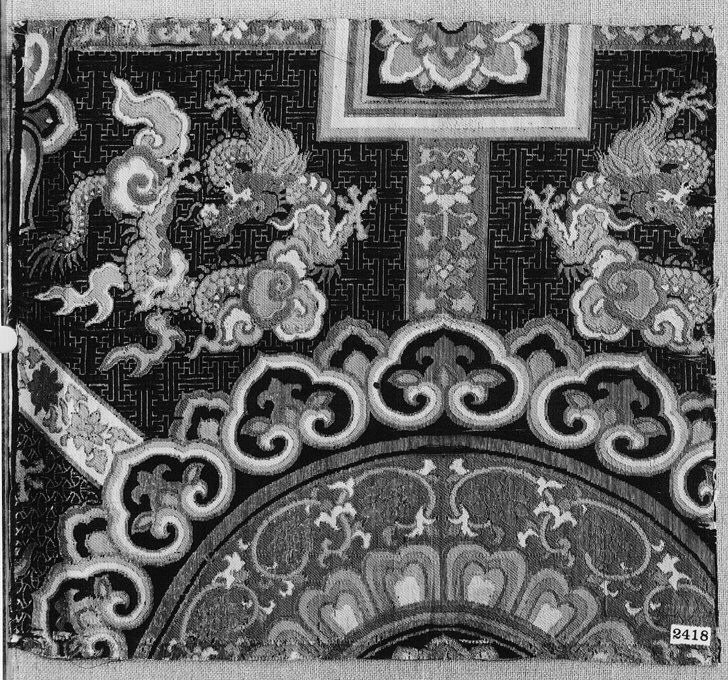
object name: piece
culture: japanese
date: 1801-1900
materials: silk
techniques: brocade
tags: dragons